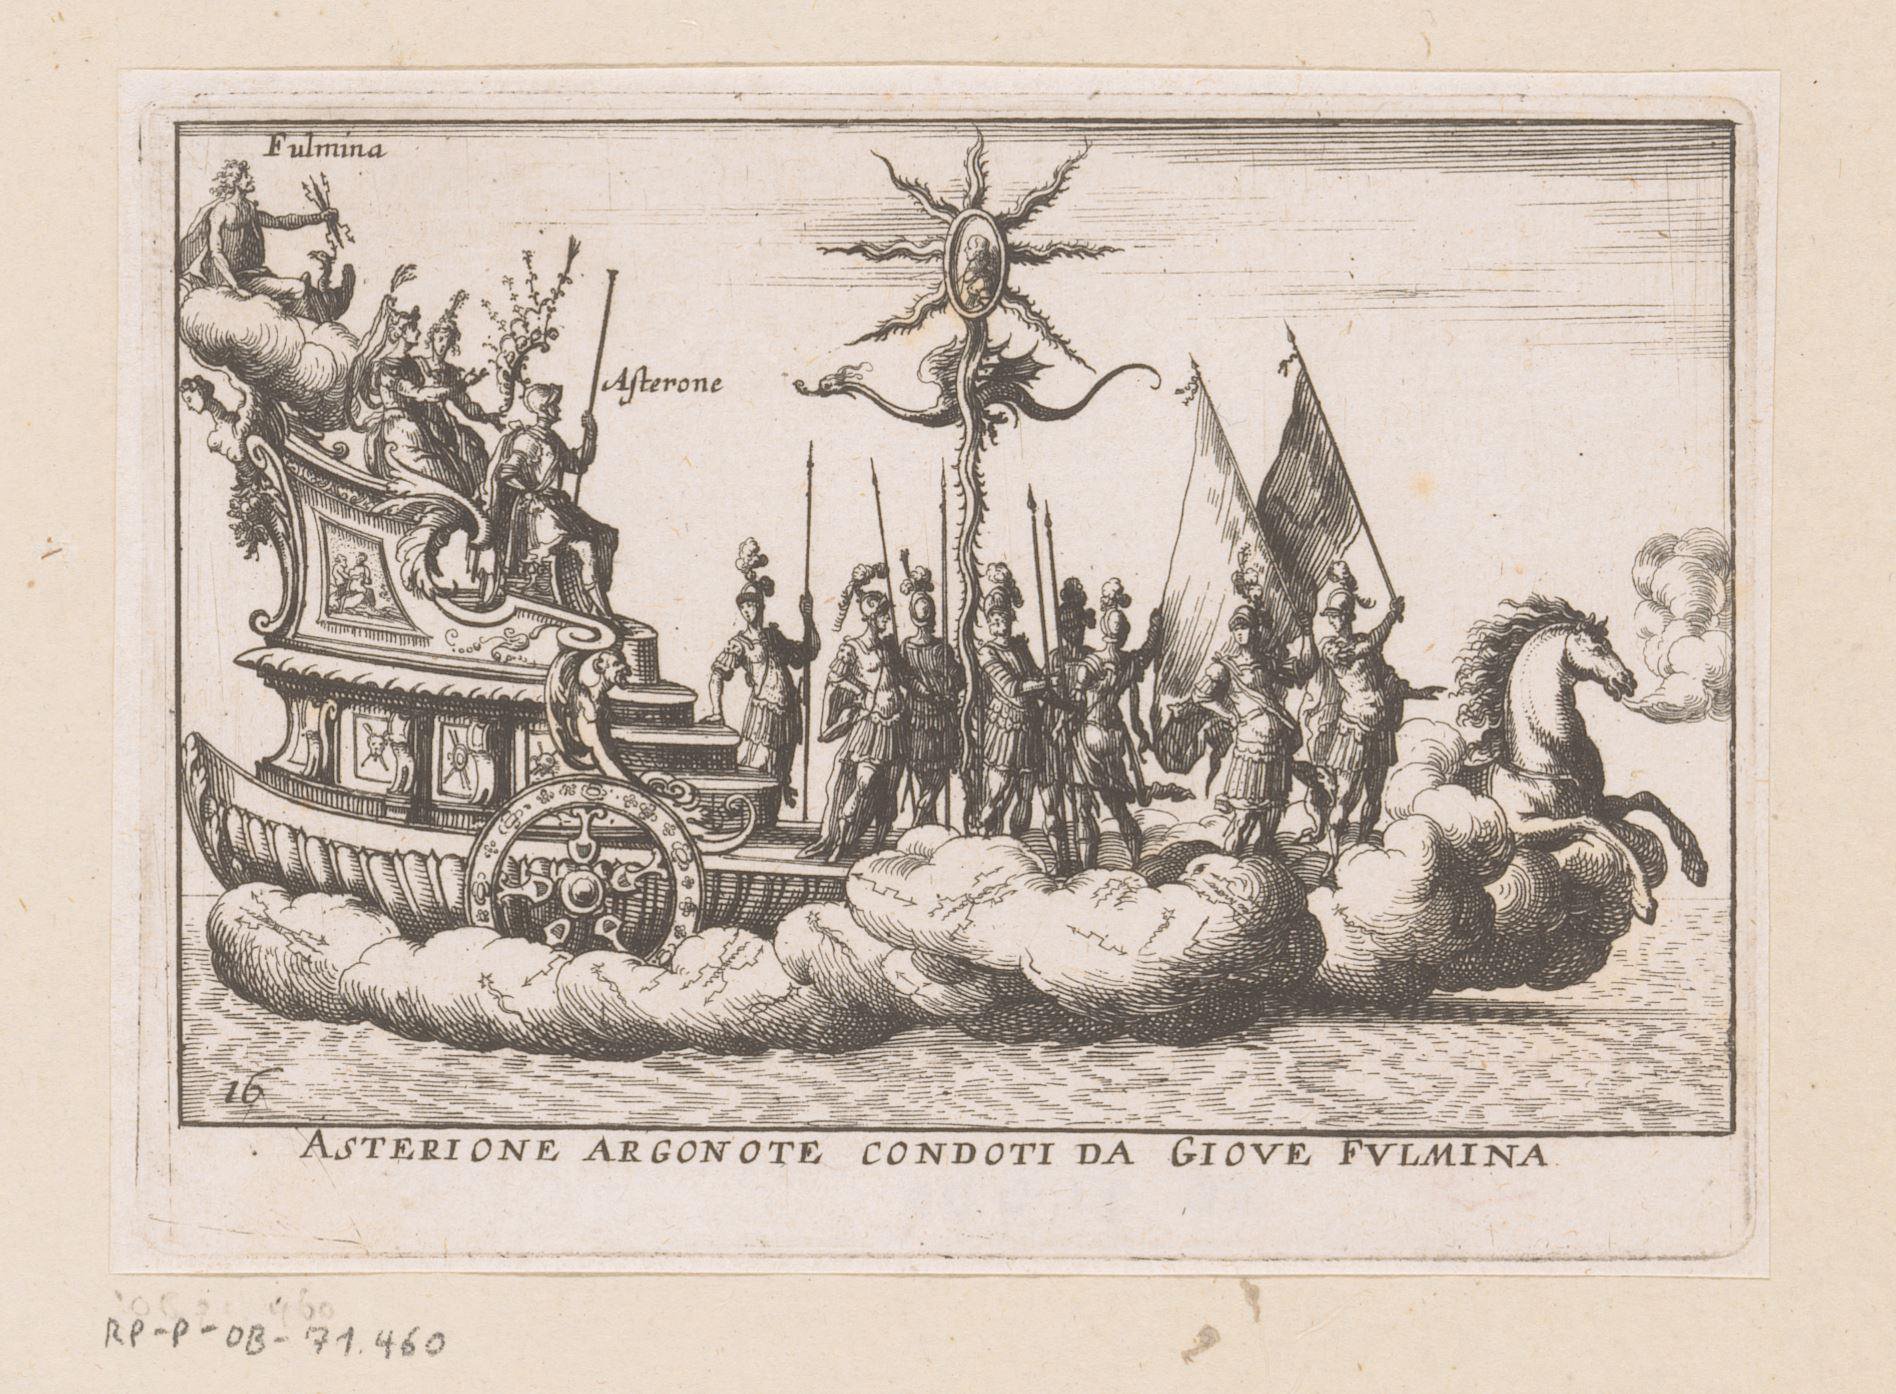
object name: print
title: Argonautenschepen voor de strijd op de Arno tijdens het huwelijksfeest van Cosimo II de' Medici te Florence in 1608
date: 1635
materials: paper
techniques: etching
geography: paris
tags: (story of) jupiter (zeus), ships (in general), the story of the argonauts: the quest for the golden fleece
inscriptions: collector's mark: Lugt 240